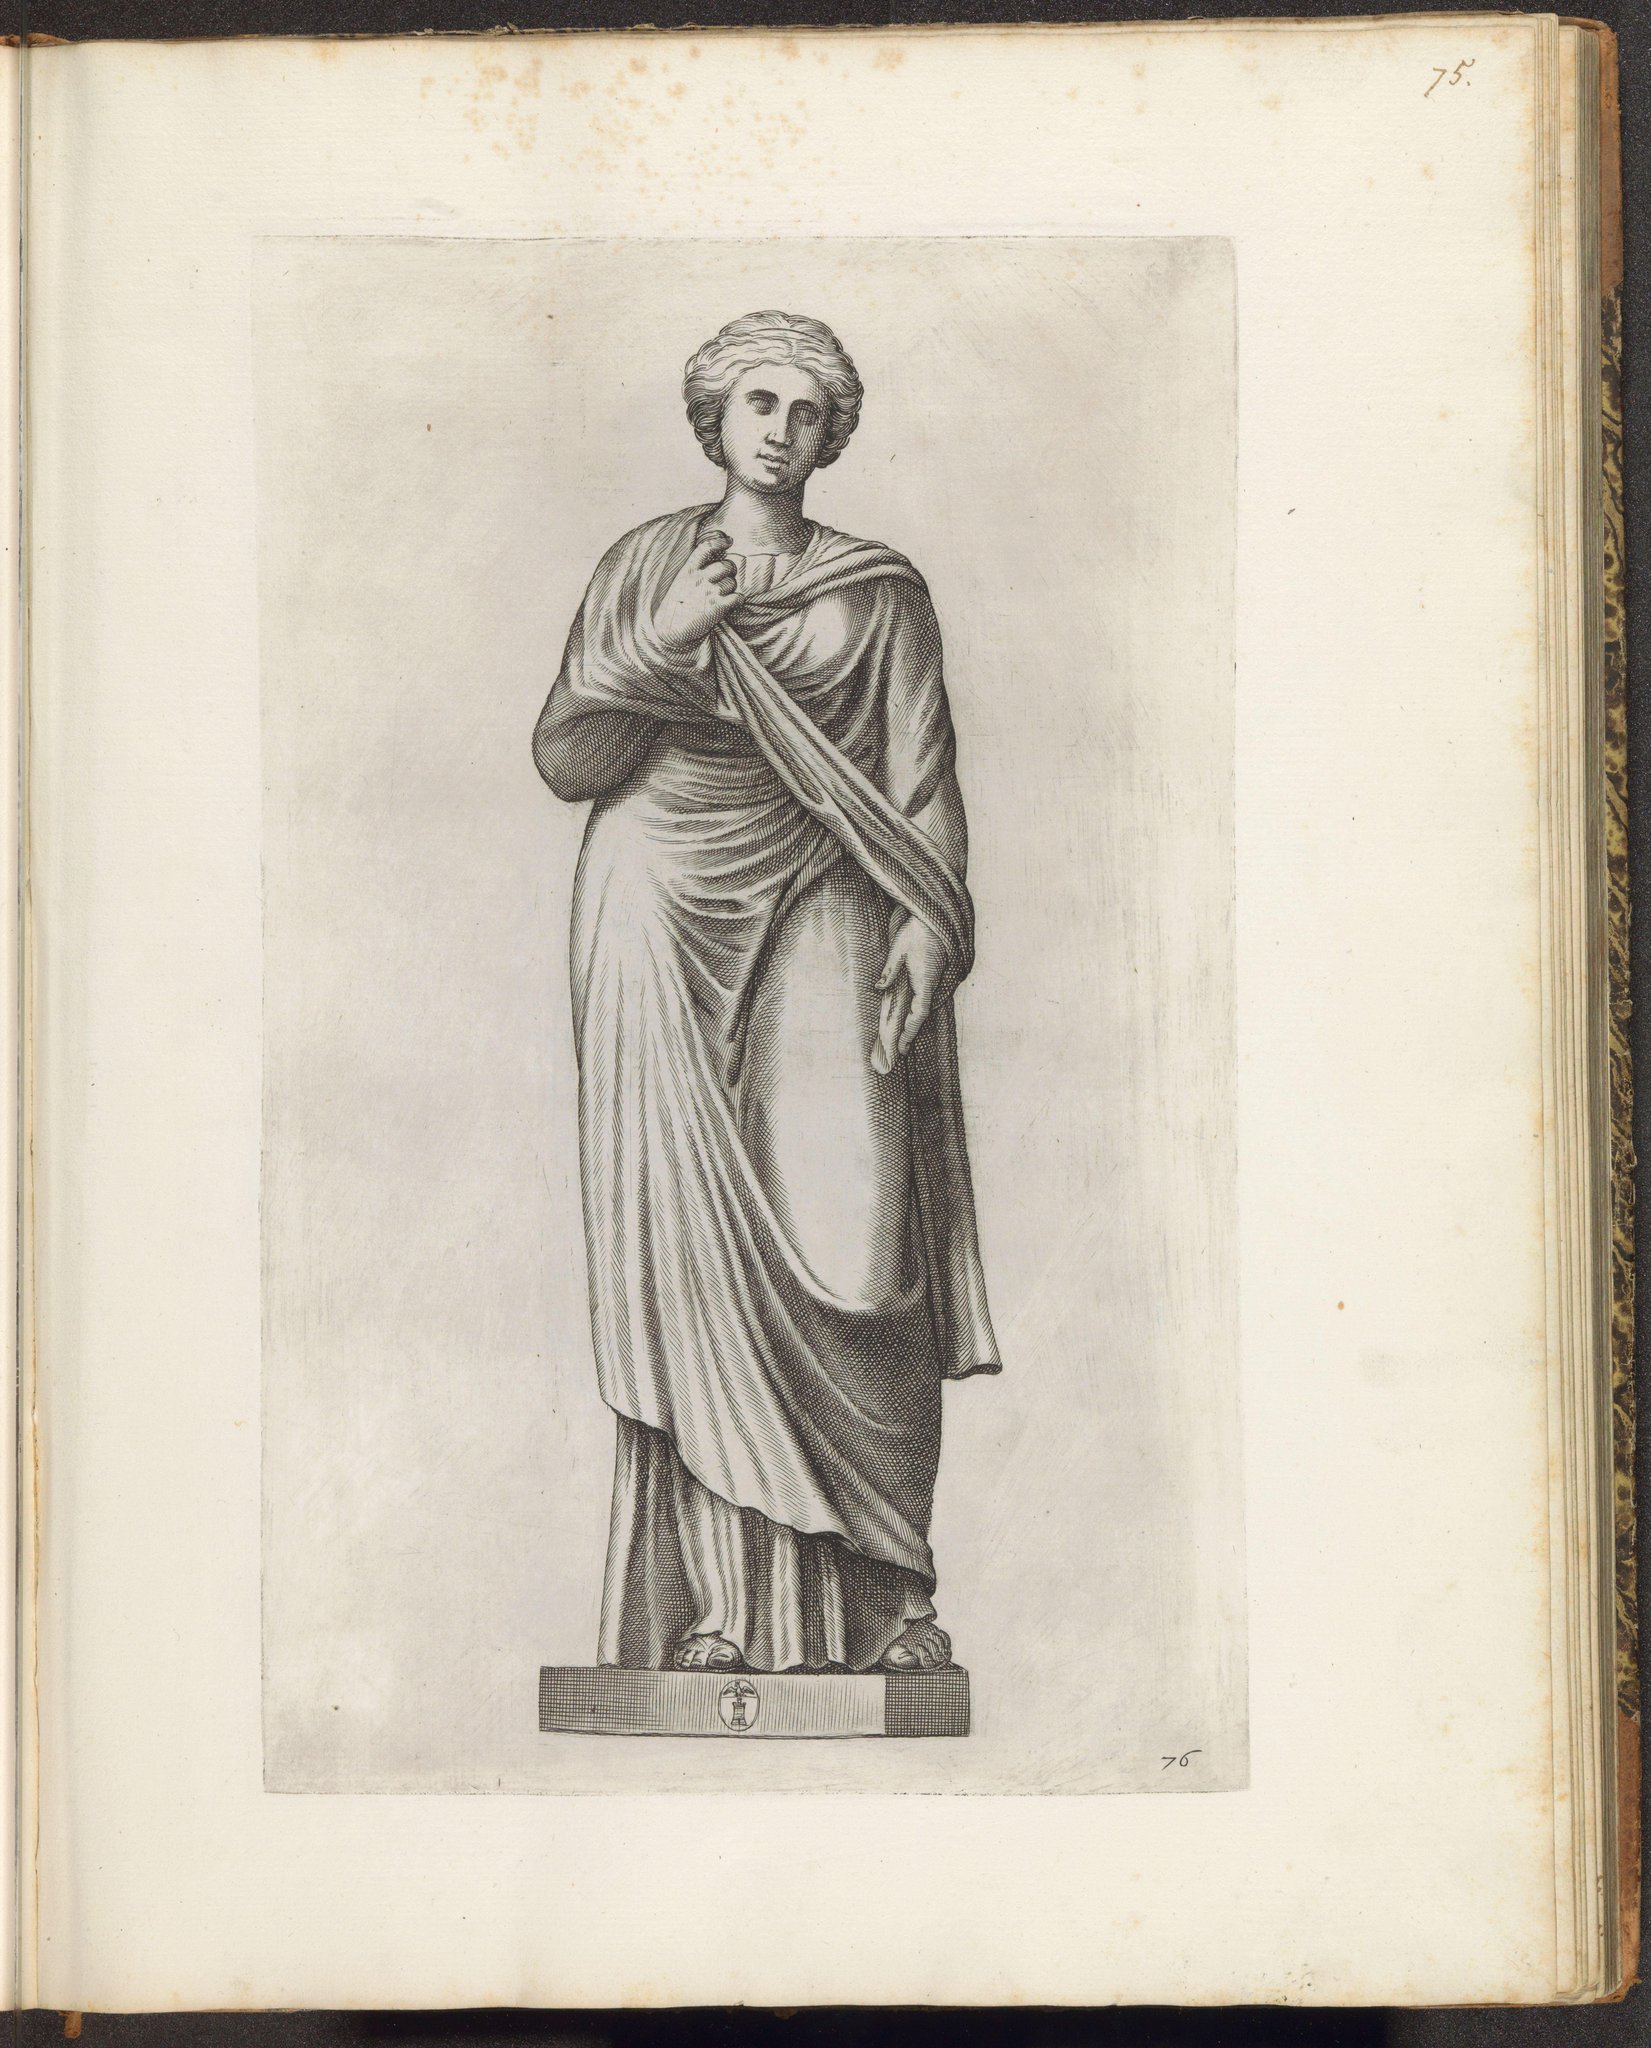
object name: print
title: Standbeeld van een staande vrouw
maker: luca ciamberlano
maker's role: painter, print maker, publisher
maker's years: 1570-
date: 1636-1647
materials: paper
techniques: engraving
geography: rome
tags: piece of sculpture, reproduction of a piece of sculpture, female persons from classical history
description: Standbeeld van een vrouw gehuld in een mantel. Op de basis het wapenschild van Vincenzo Giustiniani. Prent maakt deel uit van een album met een serie prenten naar de sculpturen in de verzameling in de Galleria Giustiniani te Rome.